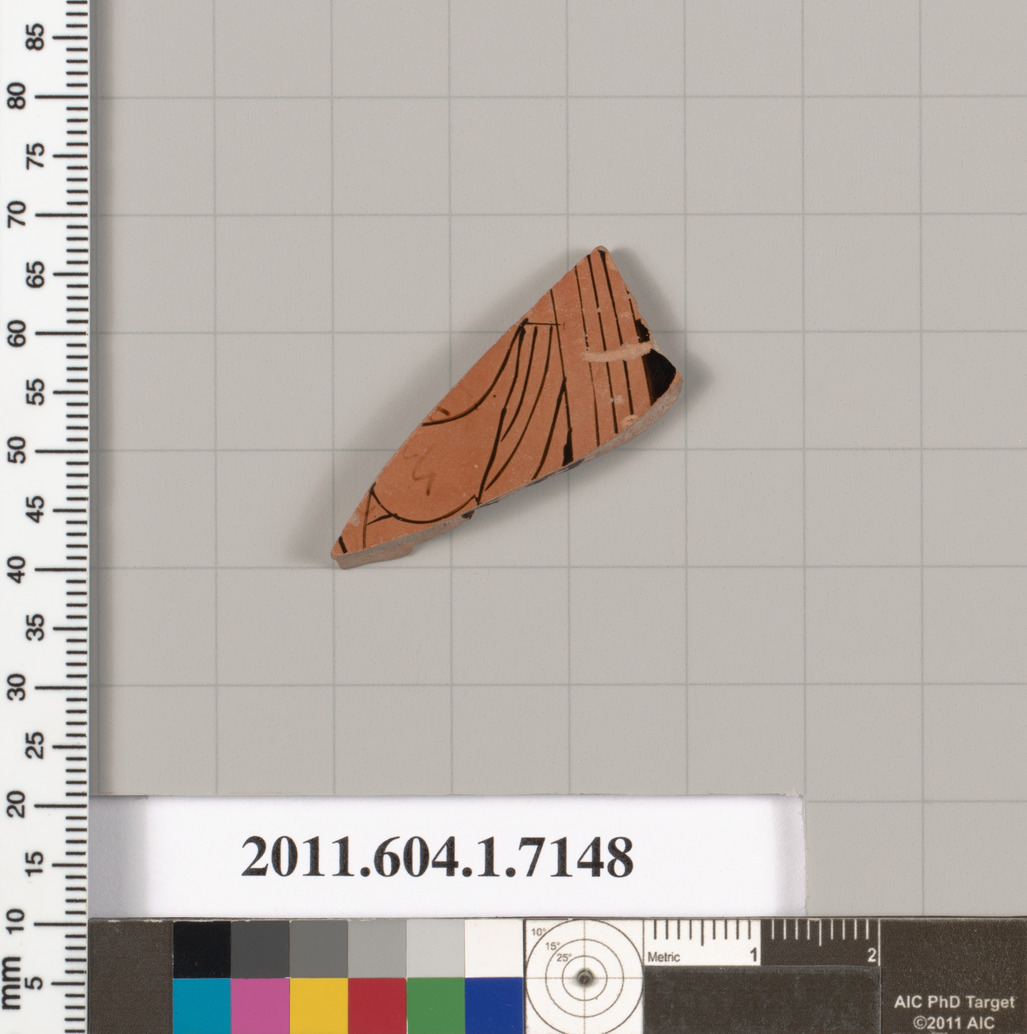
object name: kylix fragment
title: Terracotta fragment of a kylix (drinking cup)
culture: greek, attic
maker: makron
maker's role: artist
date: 500-480 BCE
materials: terracotta